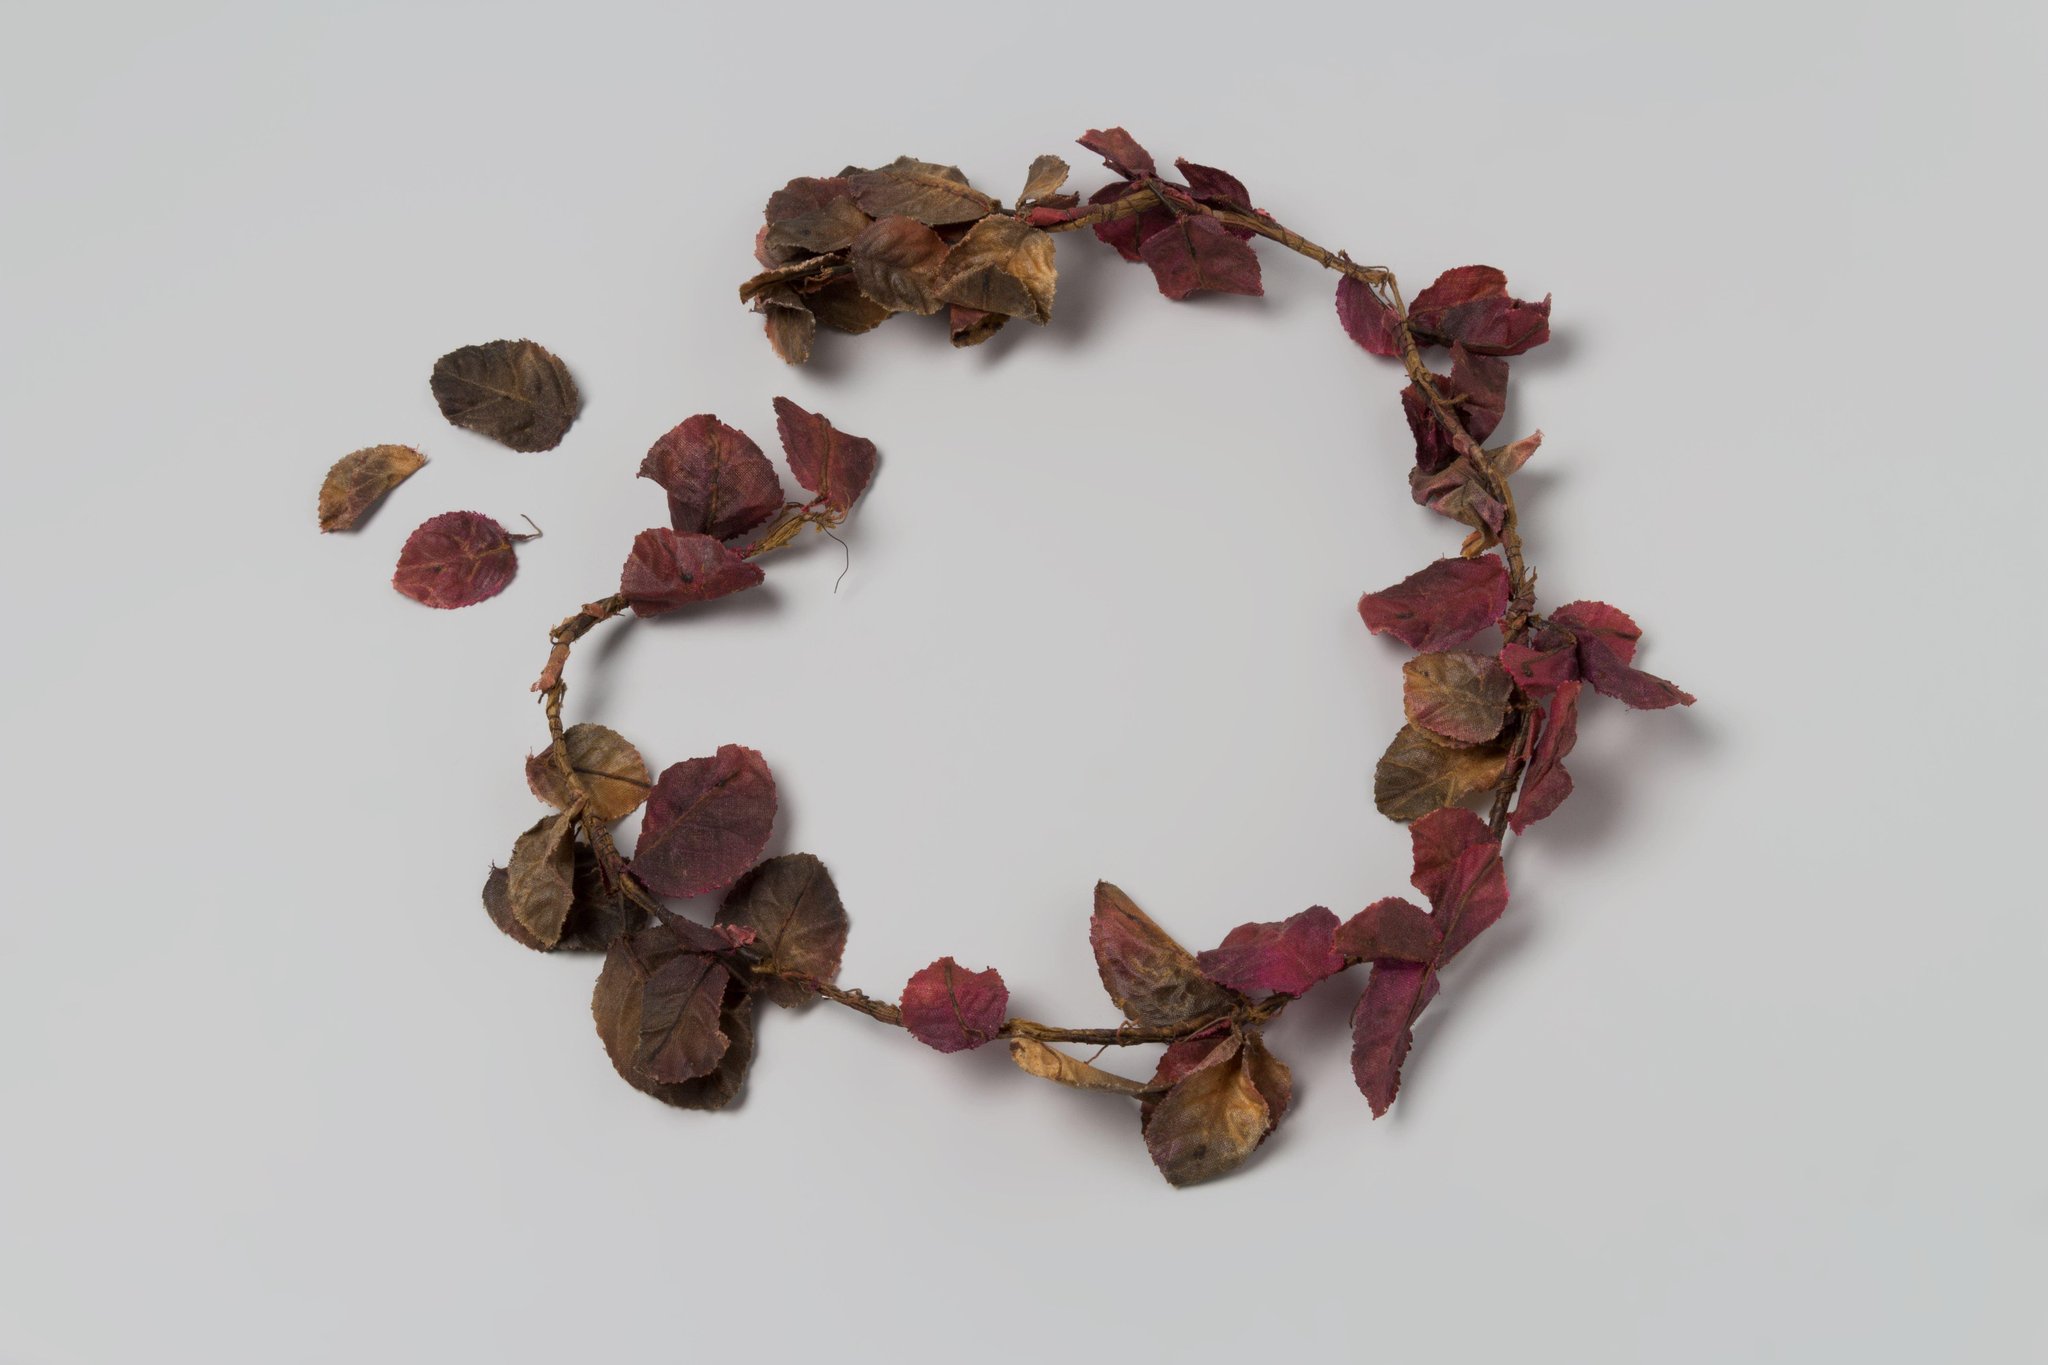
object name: hoedengarneersel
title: Krans van herfstrode en -bruine bladeren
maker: Anonymous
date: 1900-1910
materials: silk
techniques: wrapping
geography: netherlands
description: Krans van herfstrode en -bruine bladeren van synthetische zijde, met ijzerdraad omwikkelde takken. Hoedengarneersel of corsage.